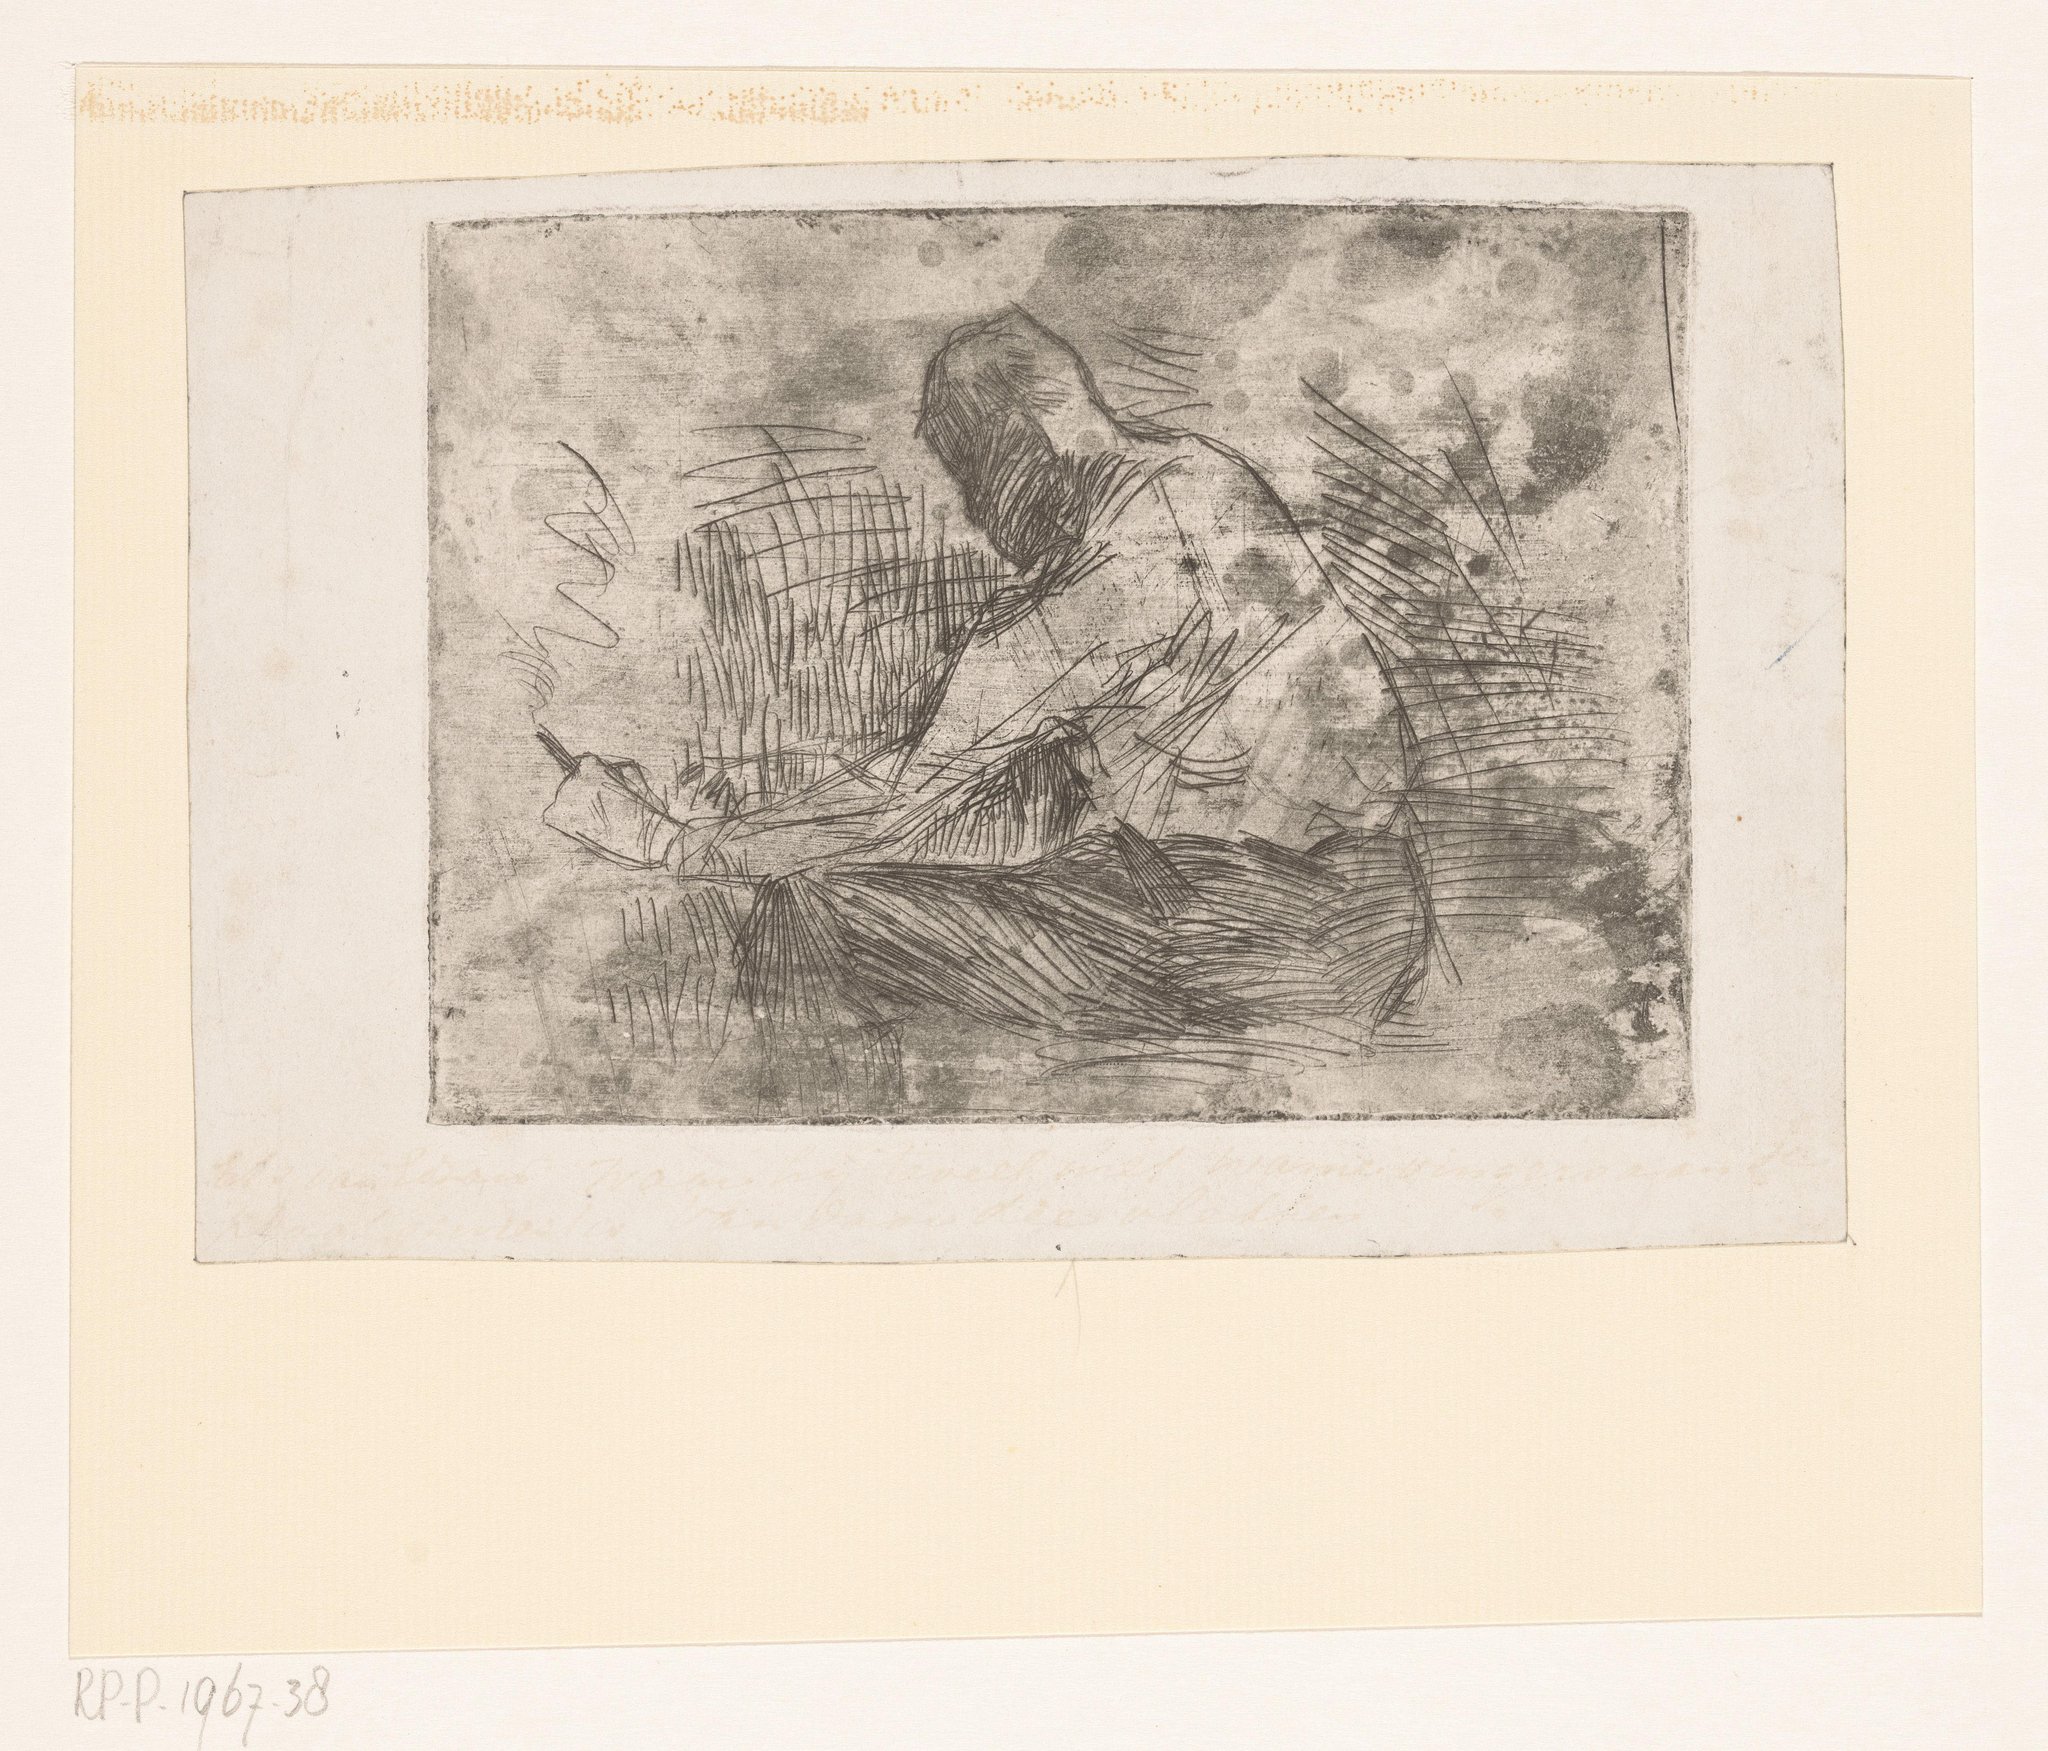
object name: print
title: Zittende man met sigaret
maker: edzard koning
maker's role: draughtsman, print maker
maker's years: 1869-1954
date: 1879-1954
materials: paper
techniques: etching, intaglio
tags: cigarette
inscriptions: inscription: ‘Ets van Edzard waar hij te veel met warme vingers aan de plaat geweest is. Vandaar die vlekken.’, collector's mark: Lugt 2228, collector's mark: Lugt 2760